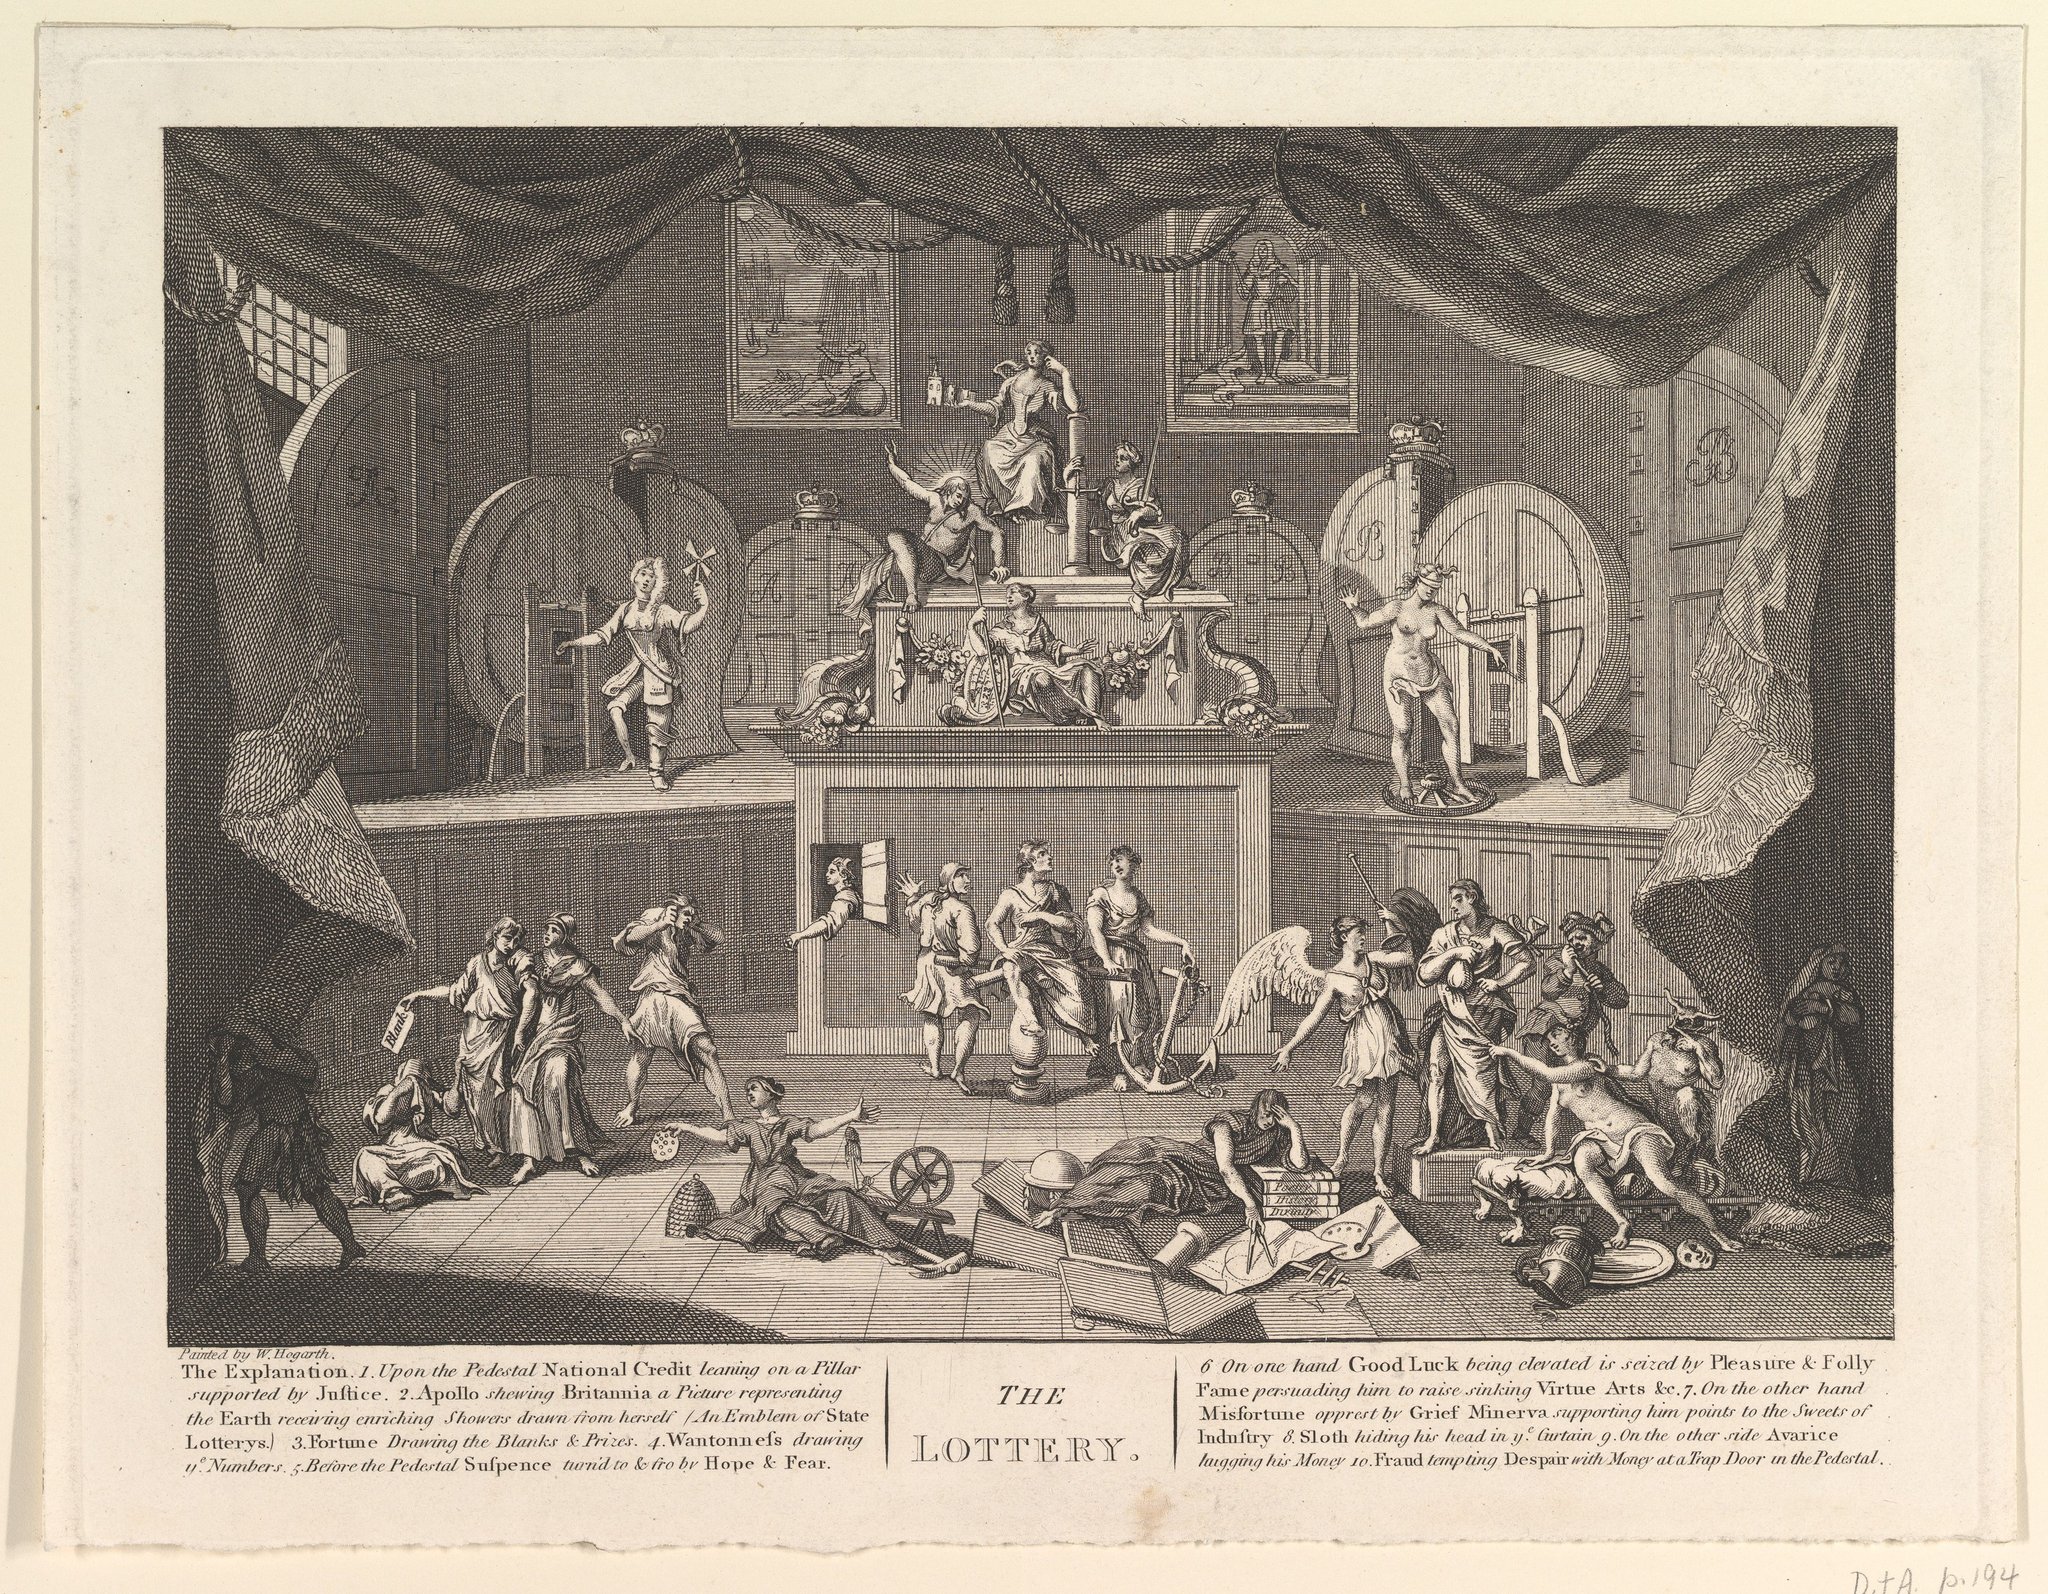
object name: print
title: The Lottery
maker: william hogarth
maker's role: artist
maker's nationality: british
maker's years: 1697-1764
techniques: engraving, etching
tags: satire,men,women